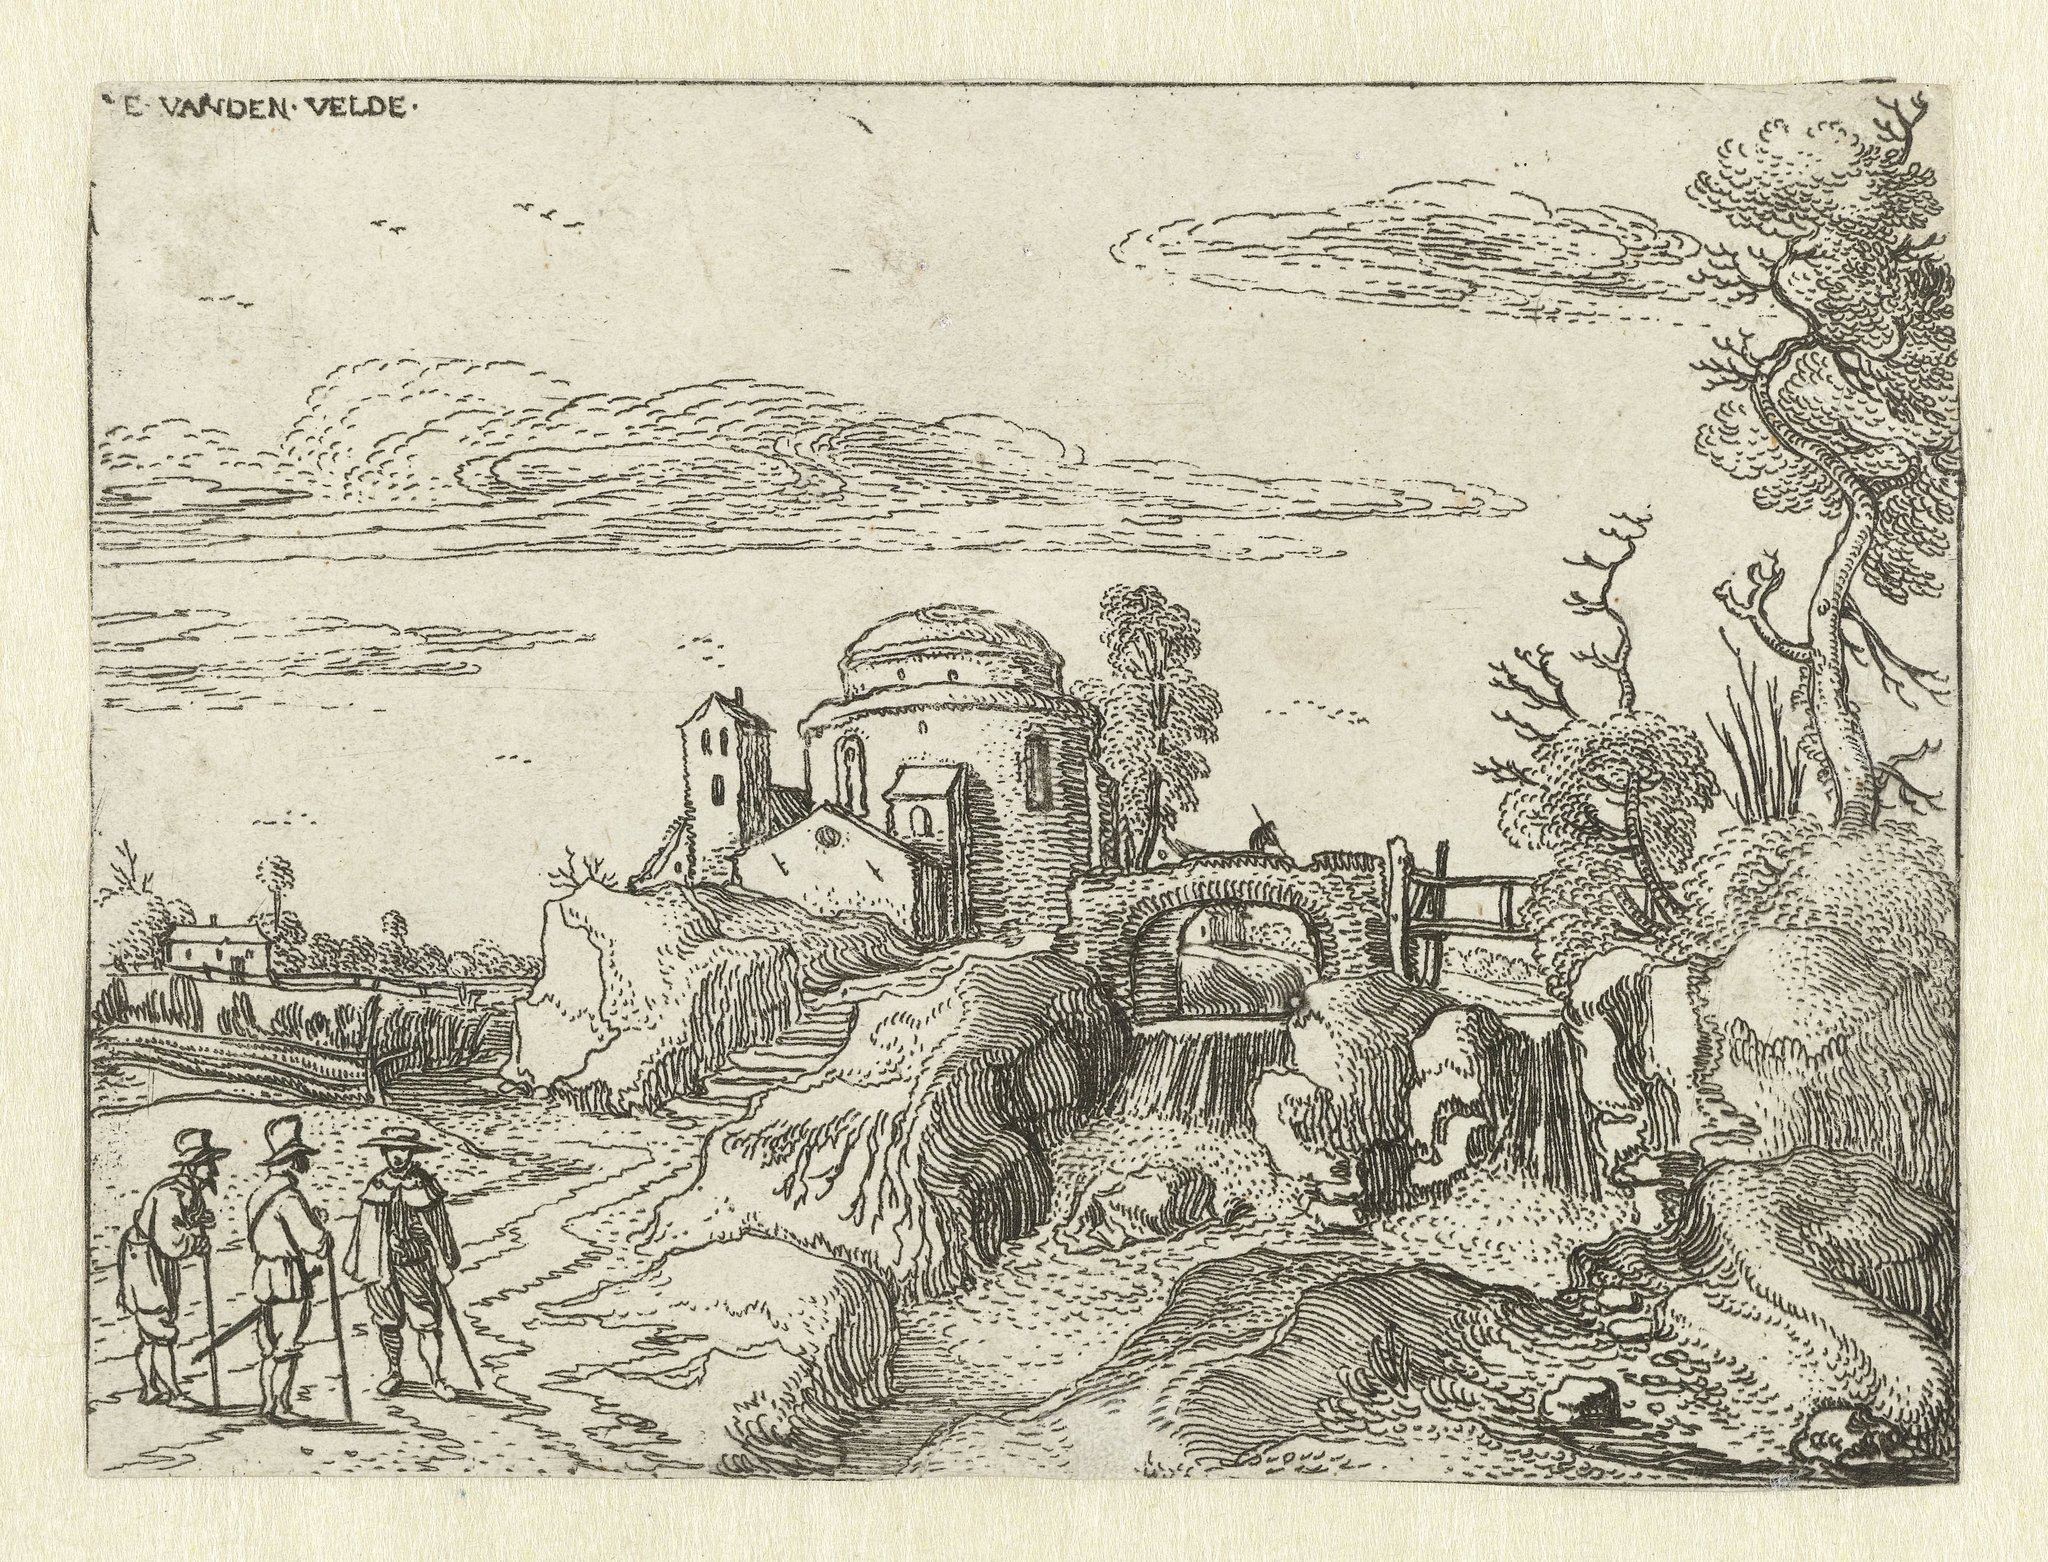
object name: print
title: Brug over waterval naast rondbouw met kapel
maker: esaias van de velde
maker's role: draughtsman, painter, print maker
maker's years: 1587-1630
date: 1615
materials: paper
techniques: etching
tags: waterfall, road, path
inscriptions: watermark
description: Op een landweg op de voorgrond links drie mannen.